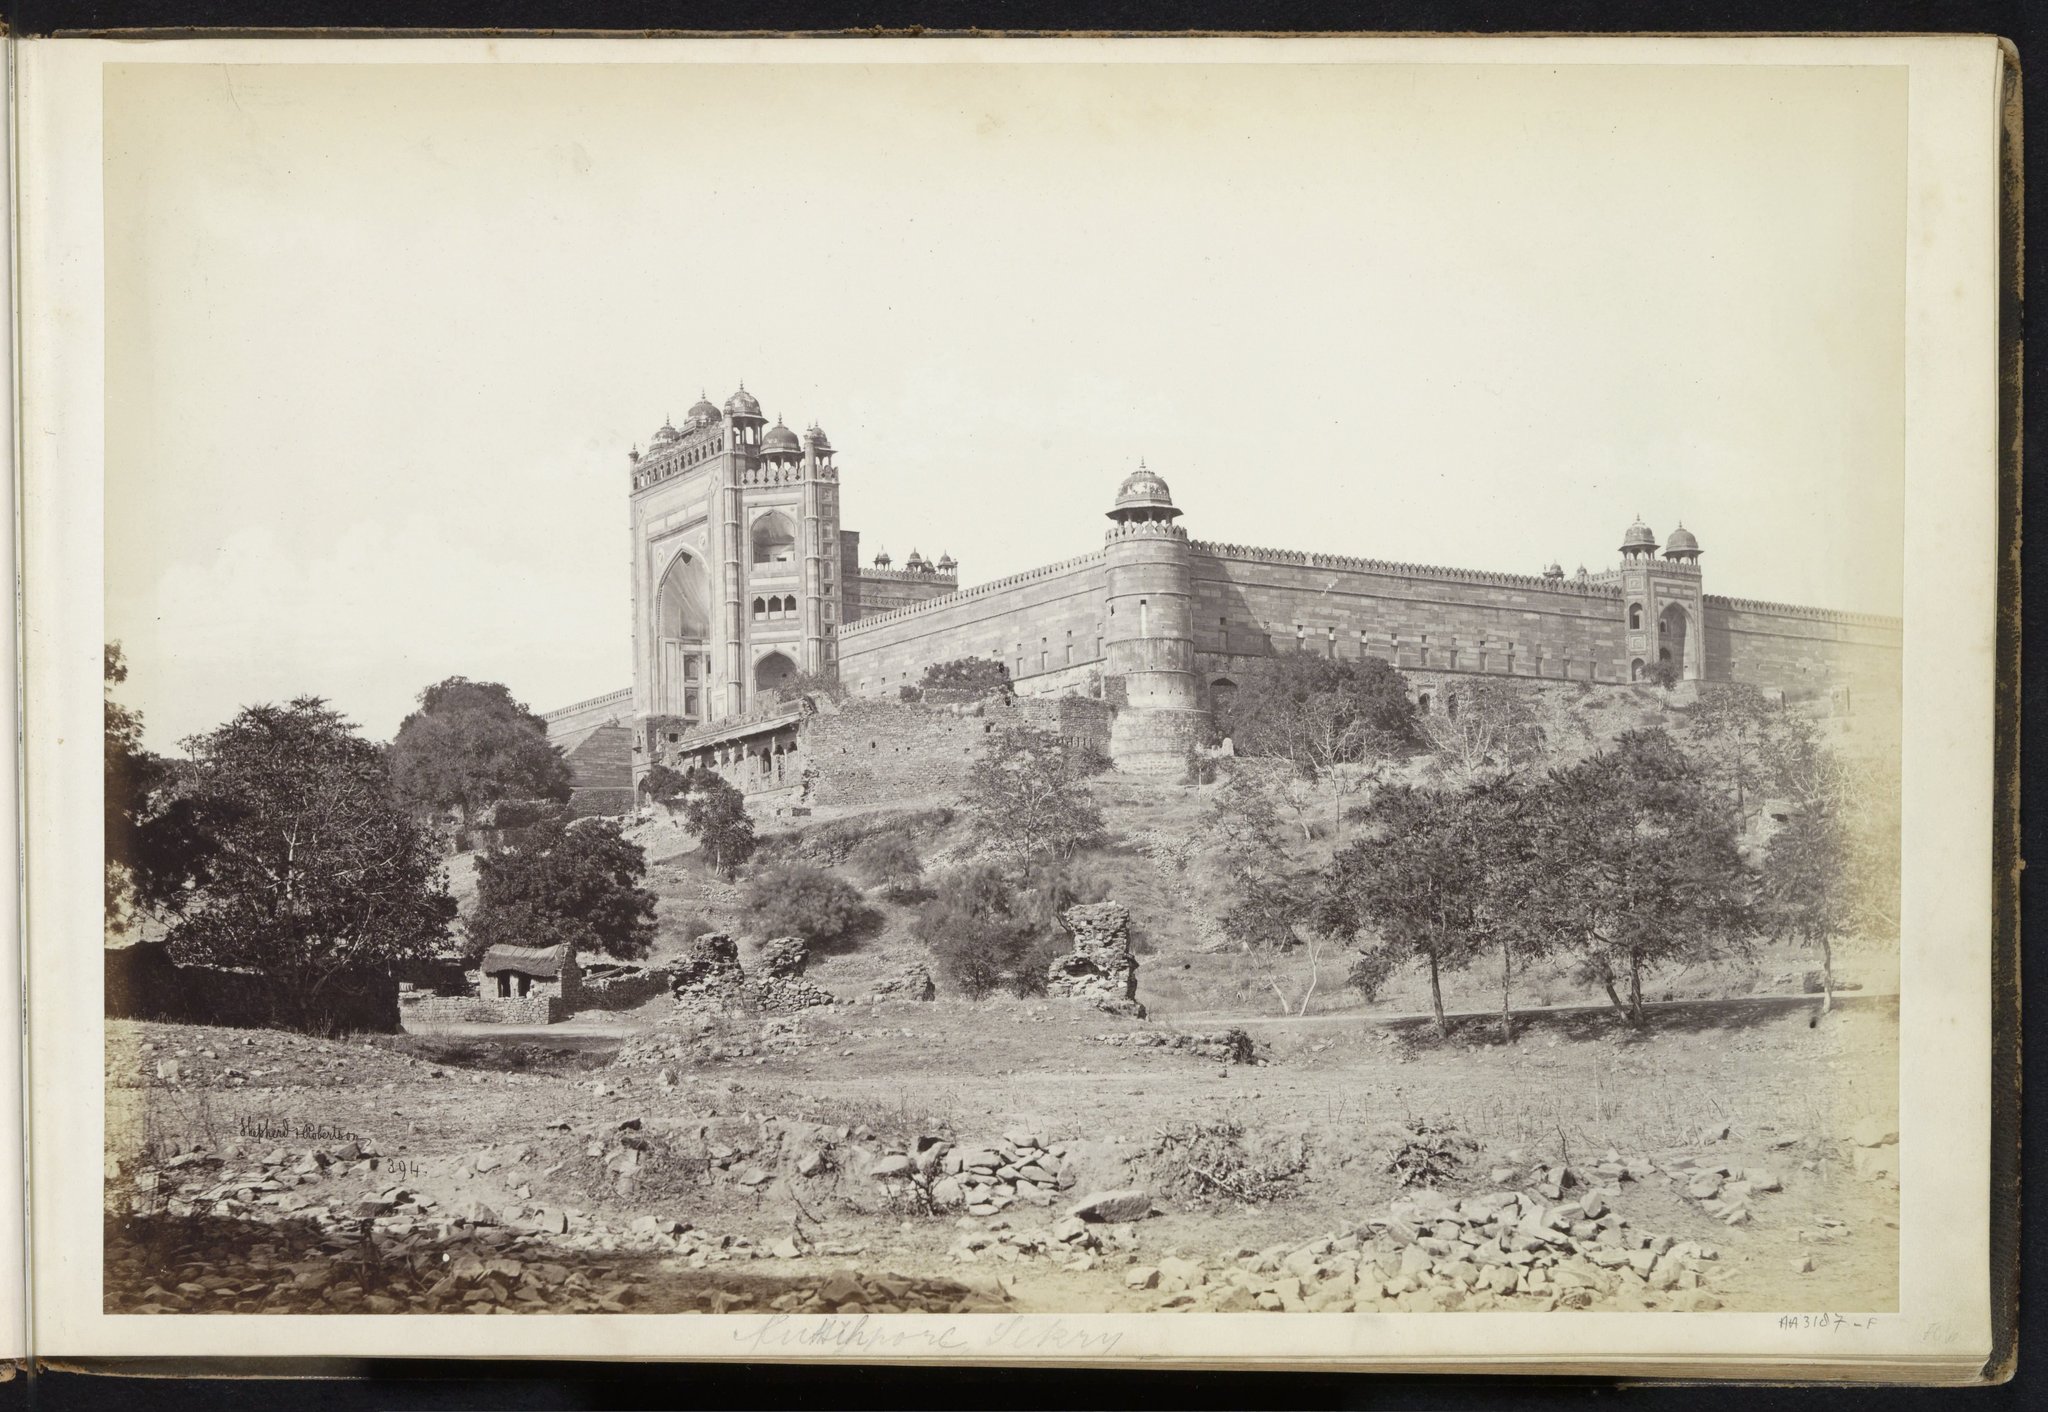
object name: photograph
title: View of the palace at Fatehpur Sikri with the Buland Darwaza portal at the left, Uttar Pradesh, India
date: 1862-1863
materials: photographic support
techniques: albumen print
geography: fatehpur sikri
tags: gate ~ fortified city, palace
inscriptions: name: ‘Shepherd & Robertson’, title: ‘Futthipore Sikry’, number: ‘394’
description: Onderdeel van Reisalbum met opnames van bezienswaardigheden in India, Duitsland, Zwitserland en Frankrijk.